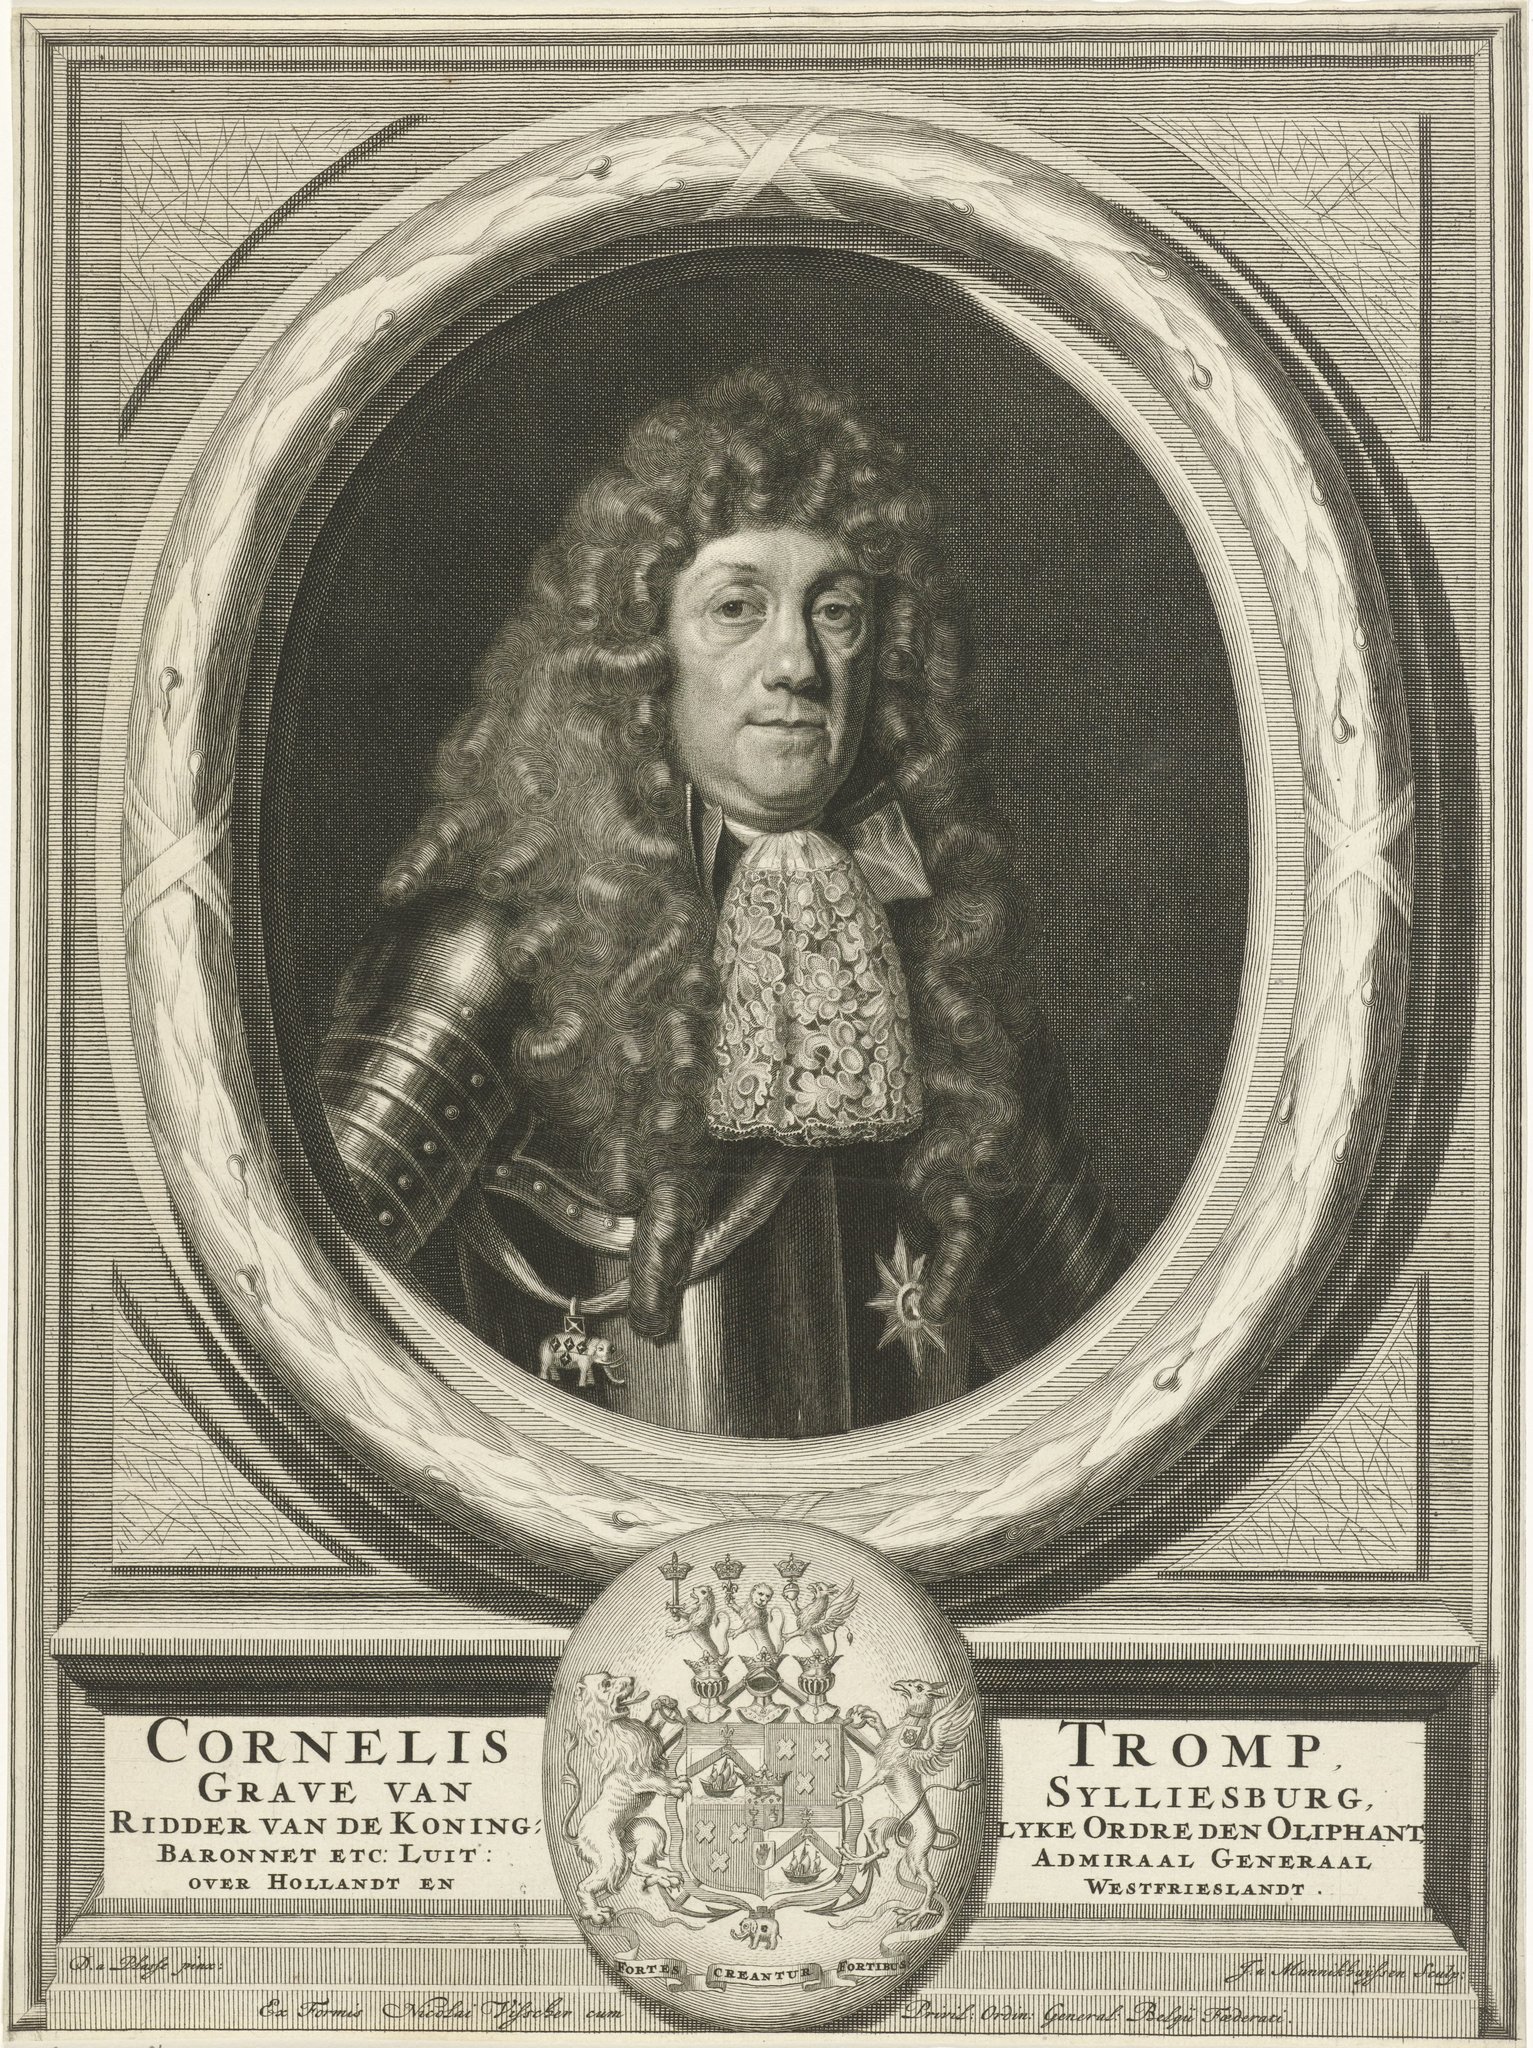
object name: print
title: Portret van Cornelis Tromp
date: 1664-1721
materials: paper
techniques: engraving, etching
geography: netherlands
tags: rotterdam, amsterdam, cornelis tromp, armour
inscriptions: collector's mark: Lugt 2228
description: Portret van Cornelis Tromp, vlootvoogd, met aan een lint het ordeteken van de Orde van de Olifant. Midden onder zijn wapenschild en devies.